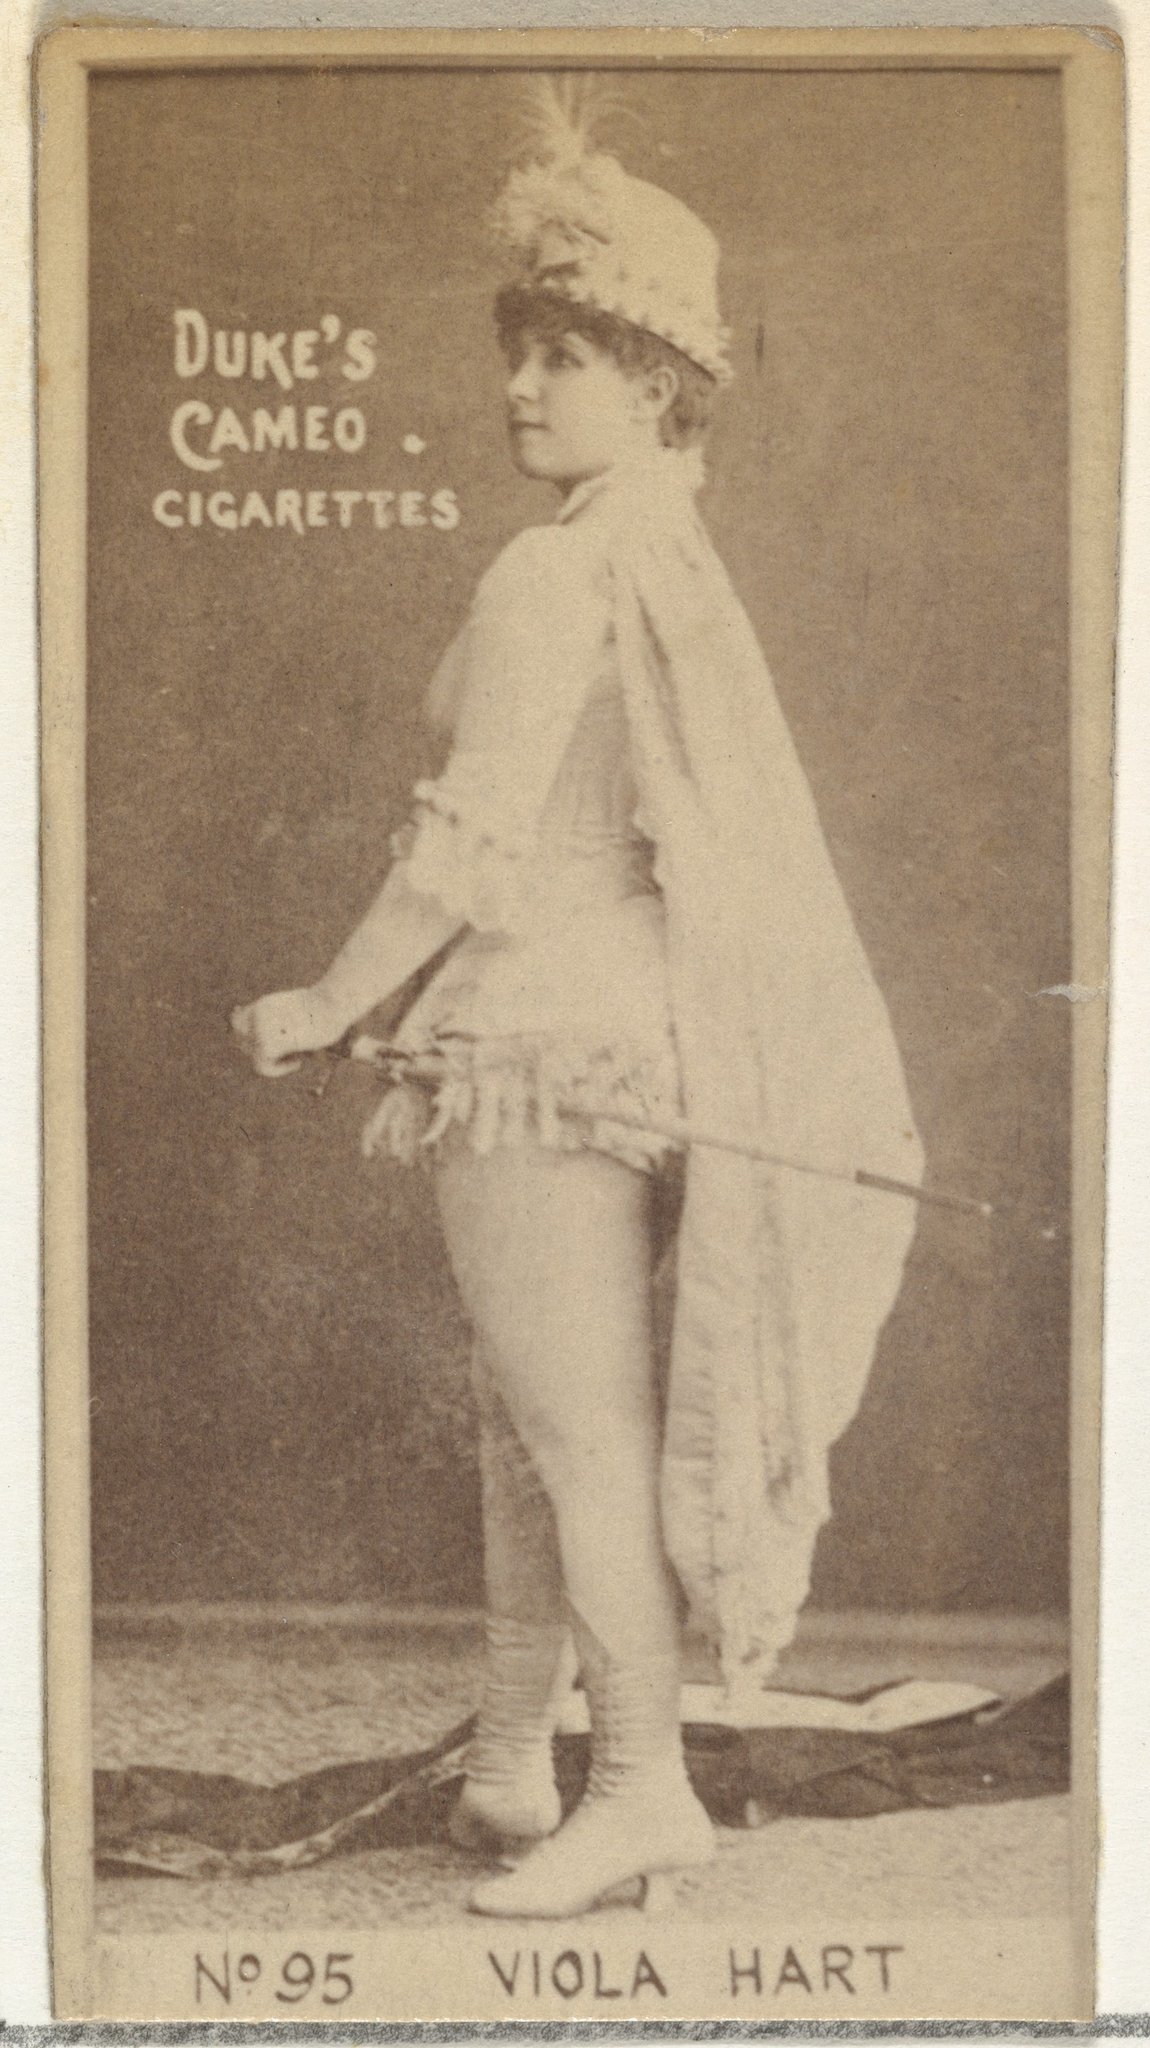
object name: photograph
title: Card Number 95, Viola Hart, from the Actors and Actresses series (N145-4) issued by Duke Sons & Co. to promote Cameo Cigarettes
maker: w. duke, sons & co.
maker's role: publisher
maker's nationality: american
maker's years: 1870-1920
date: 1880-1889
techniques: albumen silver print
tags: women,actresses